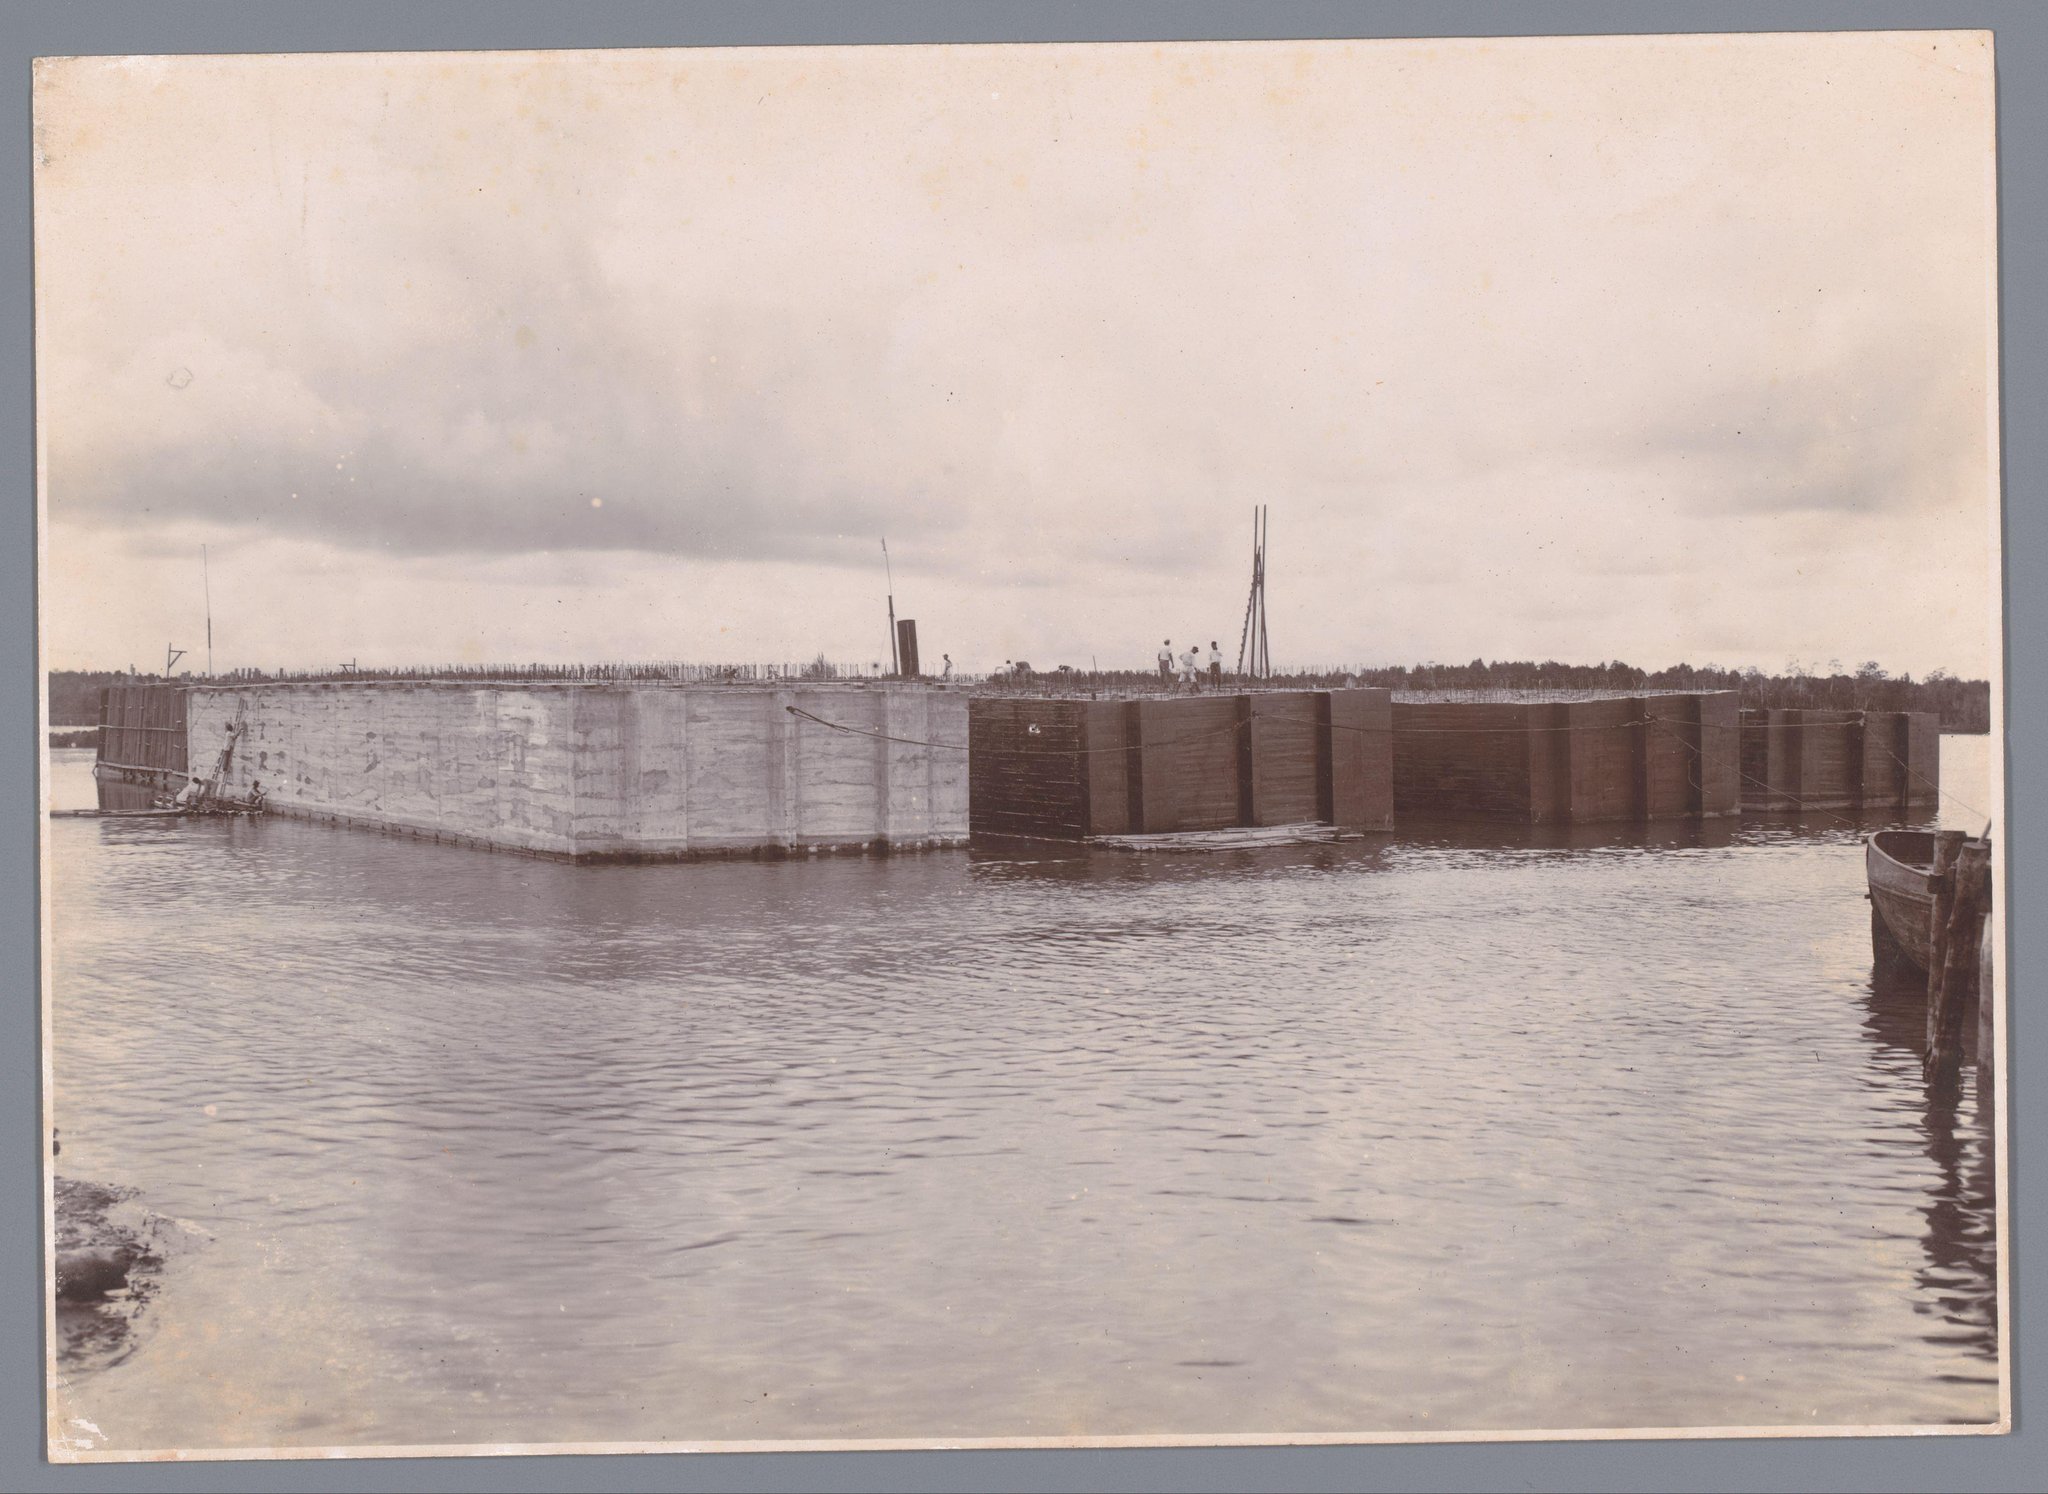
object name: photograph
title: Ontkisten, bijpleisteren en teeren der 9.09 m hooge caissons. (1e werk)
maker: Anonymous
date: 1922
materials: photographic support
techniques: gelatin silver print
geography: belawan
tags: harbour, building-site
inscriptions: inscription: ‘No. 130 Oceaanhaven Belawan / Ontkisten, bijpleisteren en teeren der 9.09 m hooge caissons. (1e werk)’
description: Afwerken van de caissons. Genummerd: 130. Onderdeel van de groep van losse foto's over de aanleg van de haven Belawan aan de kust voor Medan, Sumatra 1921-1922.